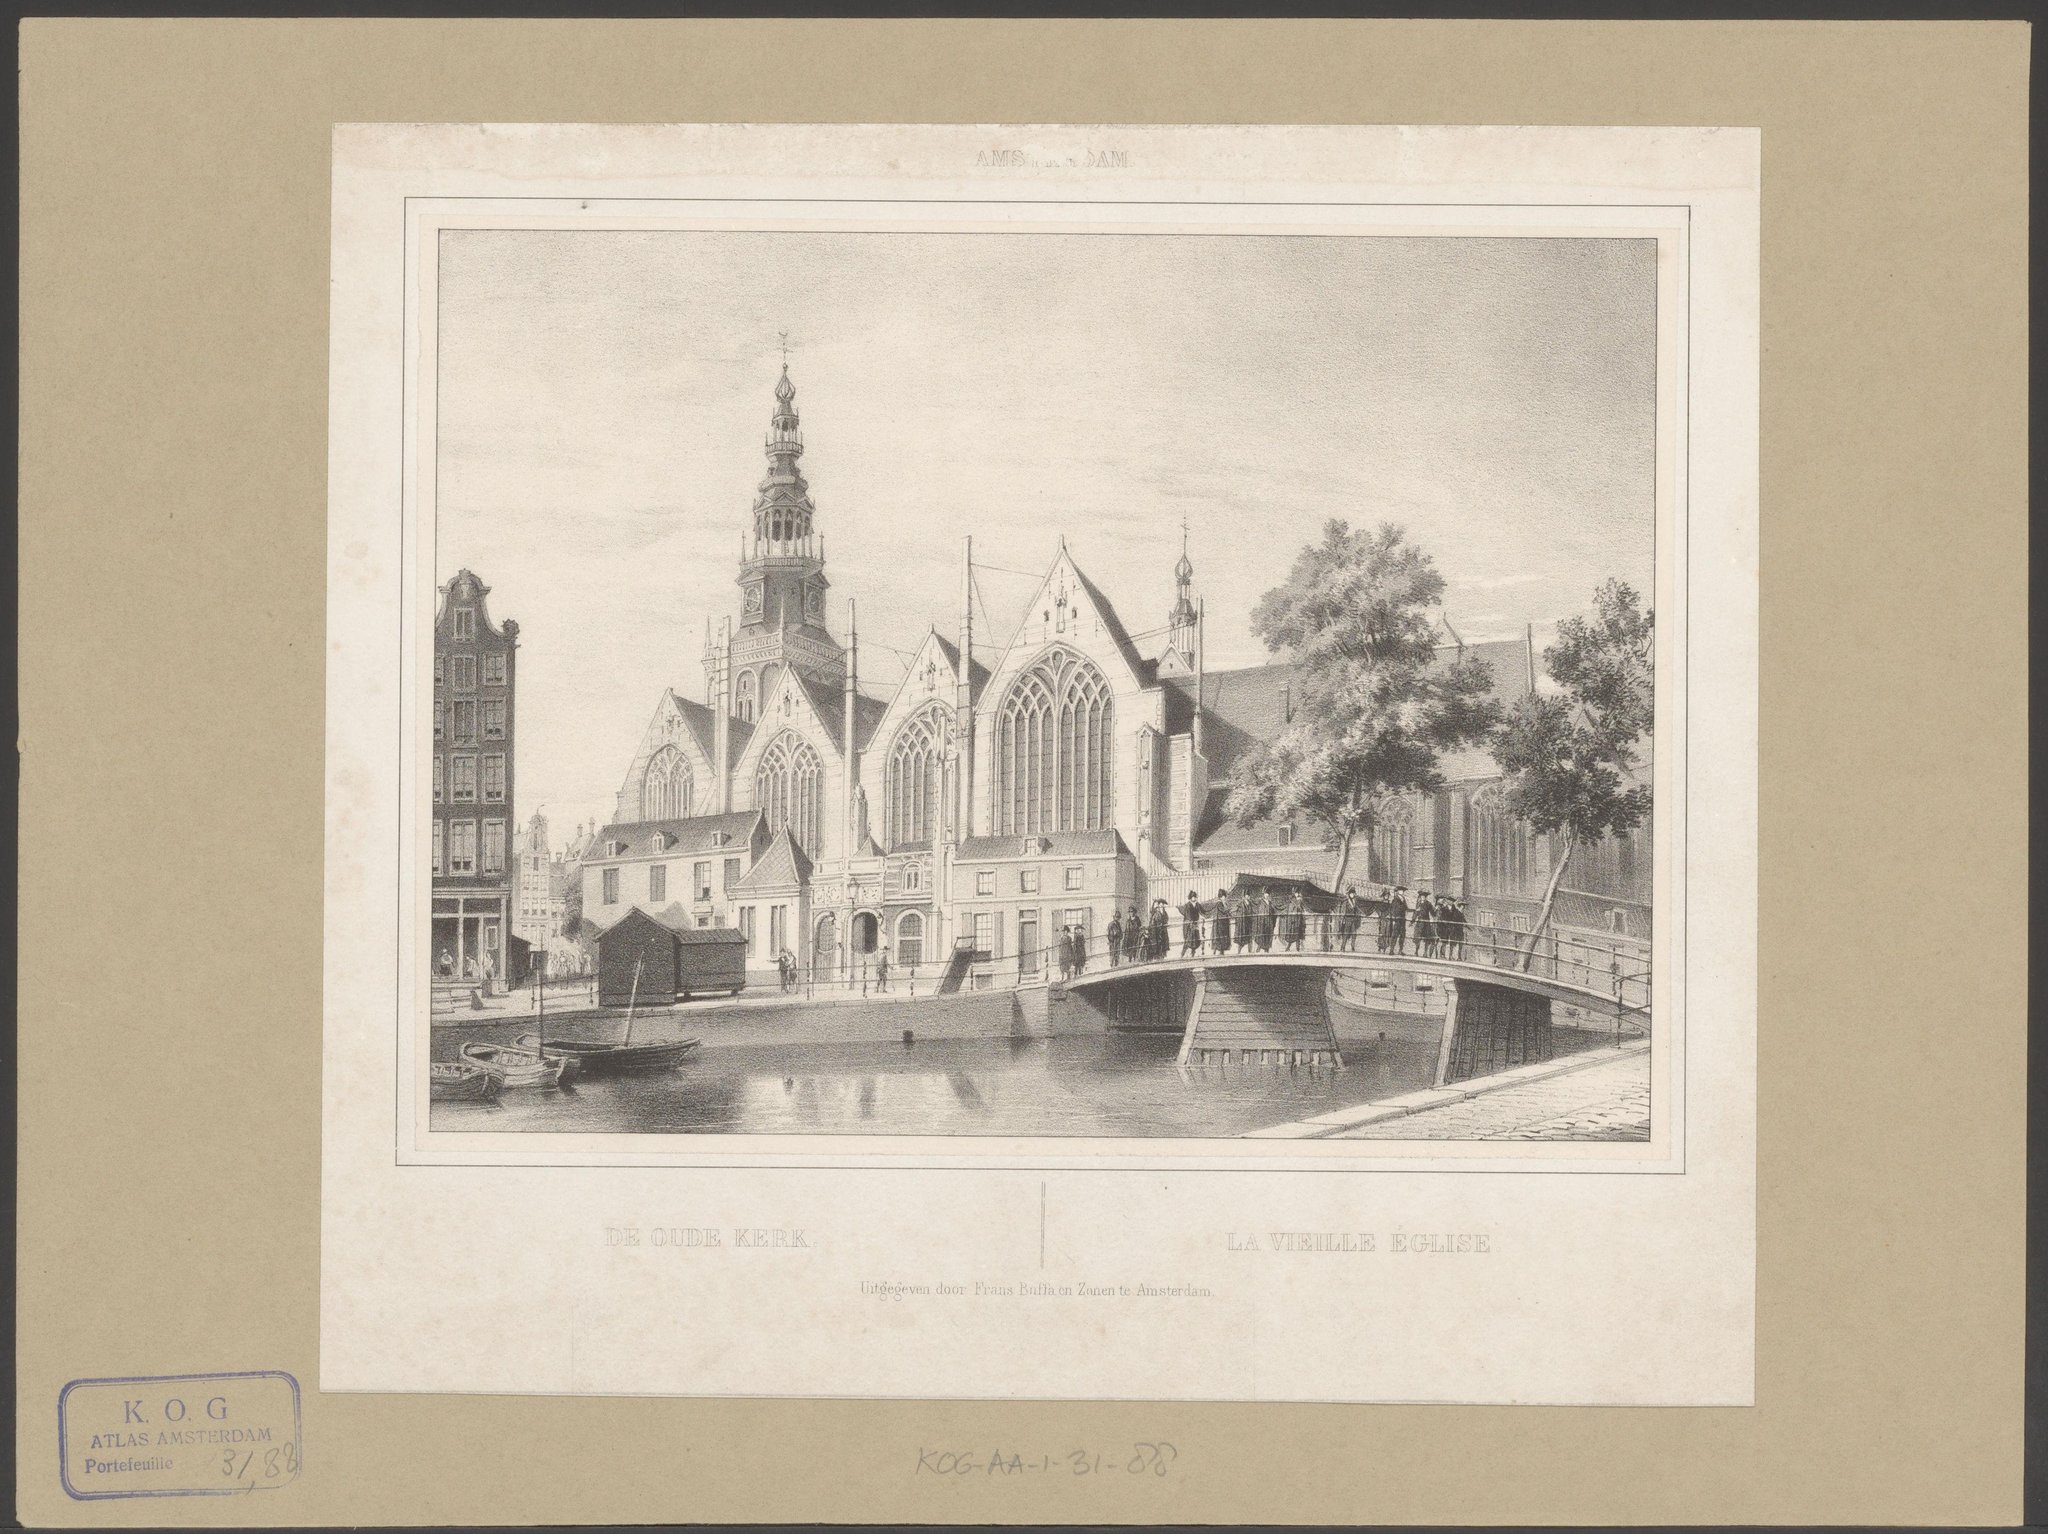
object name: print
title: De Oude Kerk / La Vieille Église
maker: Anonymous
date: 1836-1899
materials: paper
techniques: lithograph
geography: amsterdam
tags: church (exterior), canals, waters (in city)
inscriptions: collector's mark: ‘31.88’ Lugt 1641b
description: Onderwerpsrubriek binnen de Atlas Amsterdam: Kerkwezen: Hervormde Gemeente: Oude Kerk van buiten.